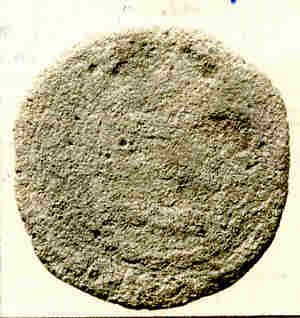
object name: coin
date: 733-793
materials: copper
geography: iran